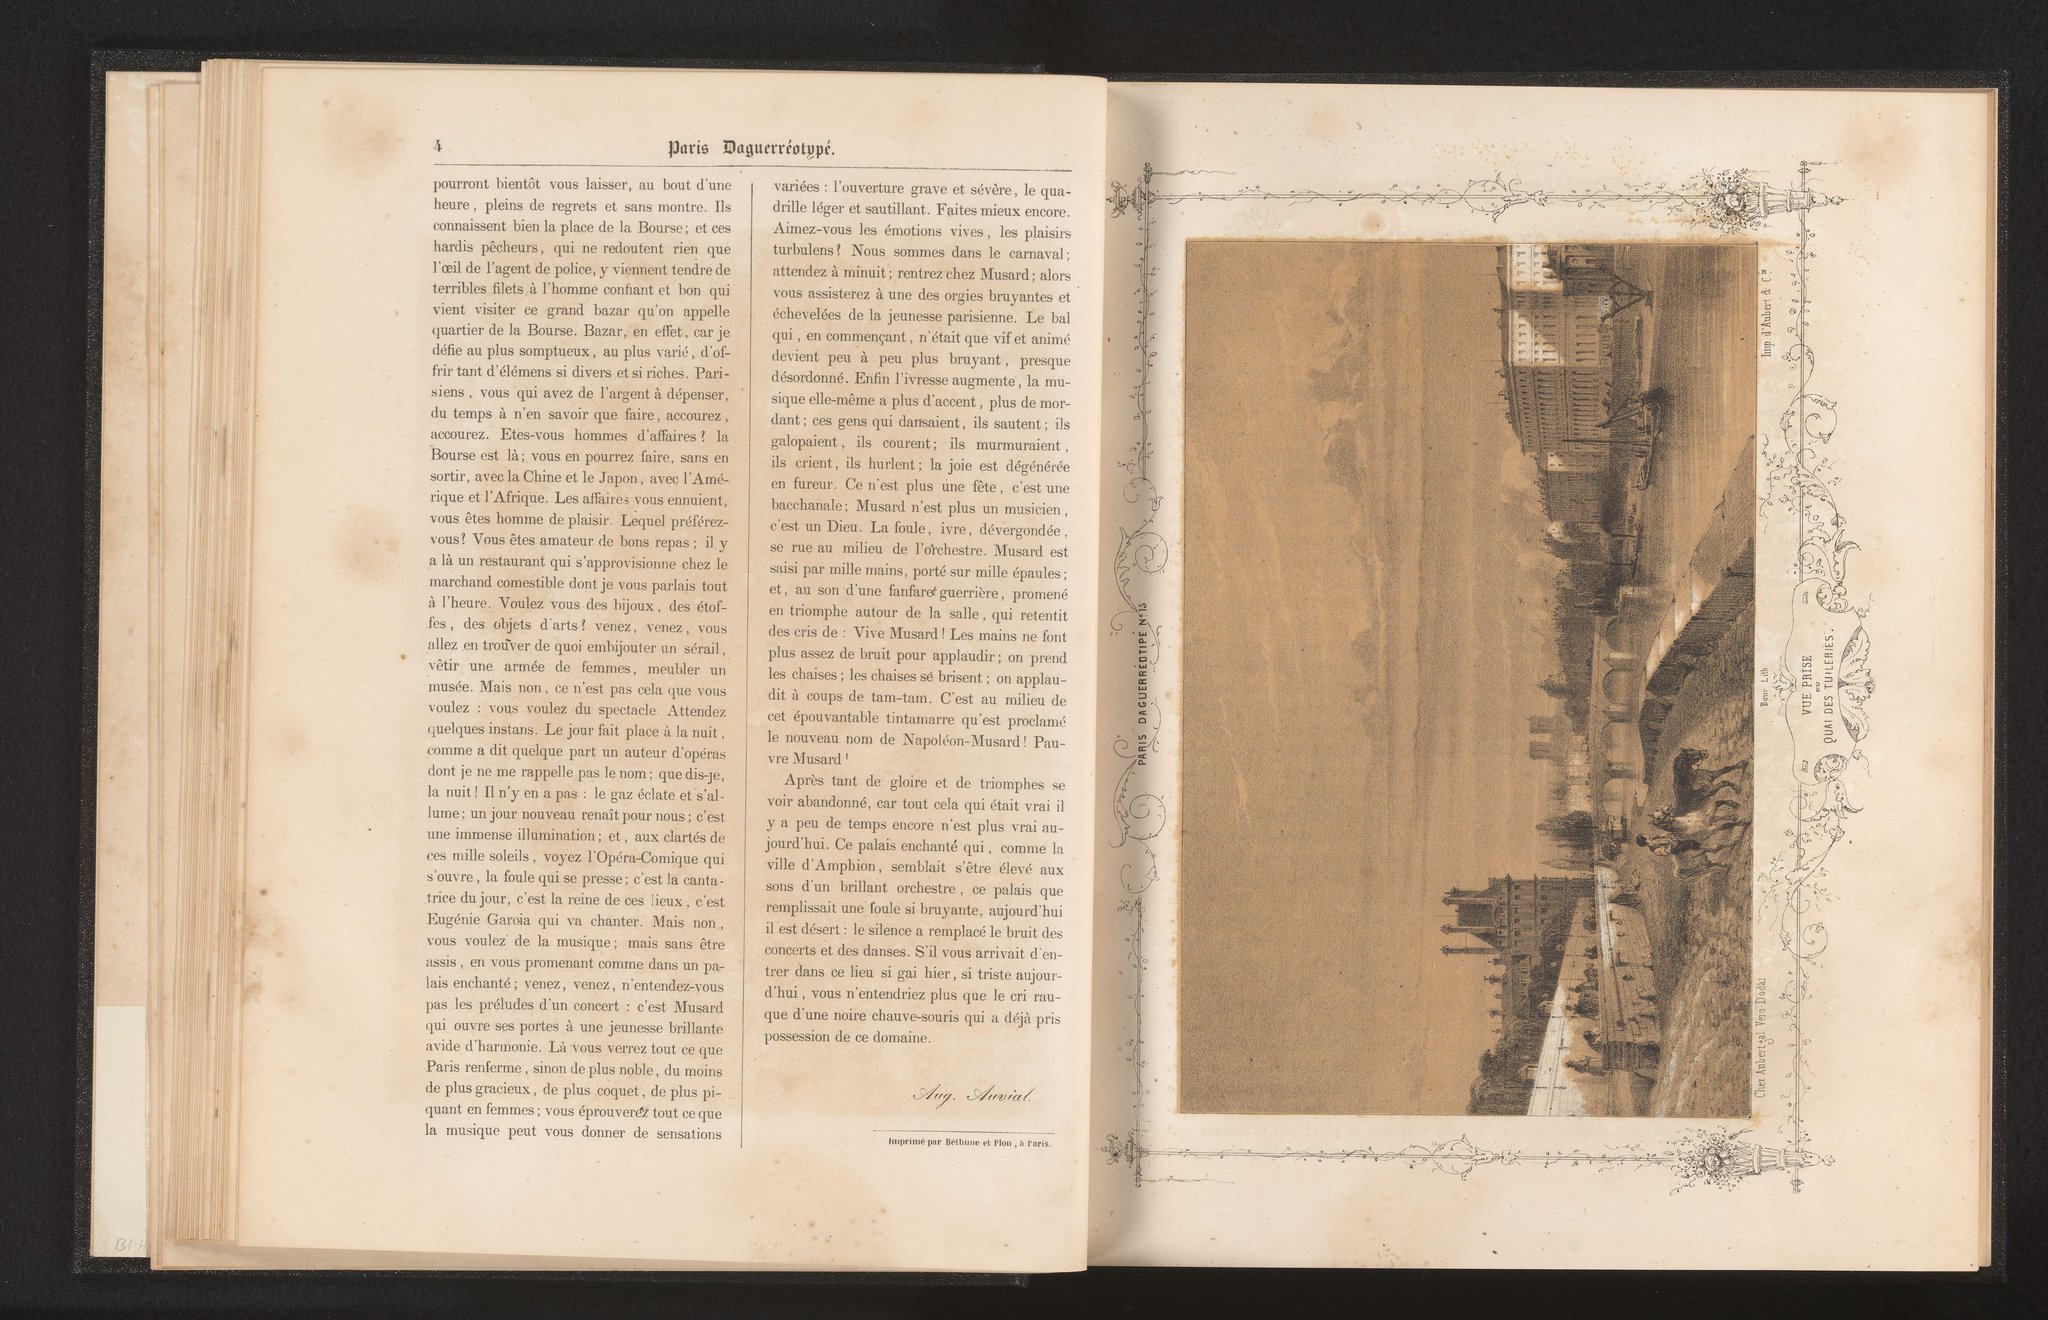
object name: page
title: Vue pris du Quai des Tuileries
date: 1839-1840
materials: paper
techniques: tone lithography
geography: paris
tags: quay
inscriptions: inscription: ‘PARIS DAGUERRÉOTYPÉ No. 15.’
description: Prent op zevenenvijftigste ongenummerde pagina.